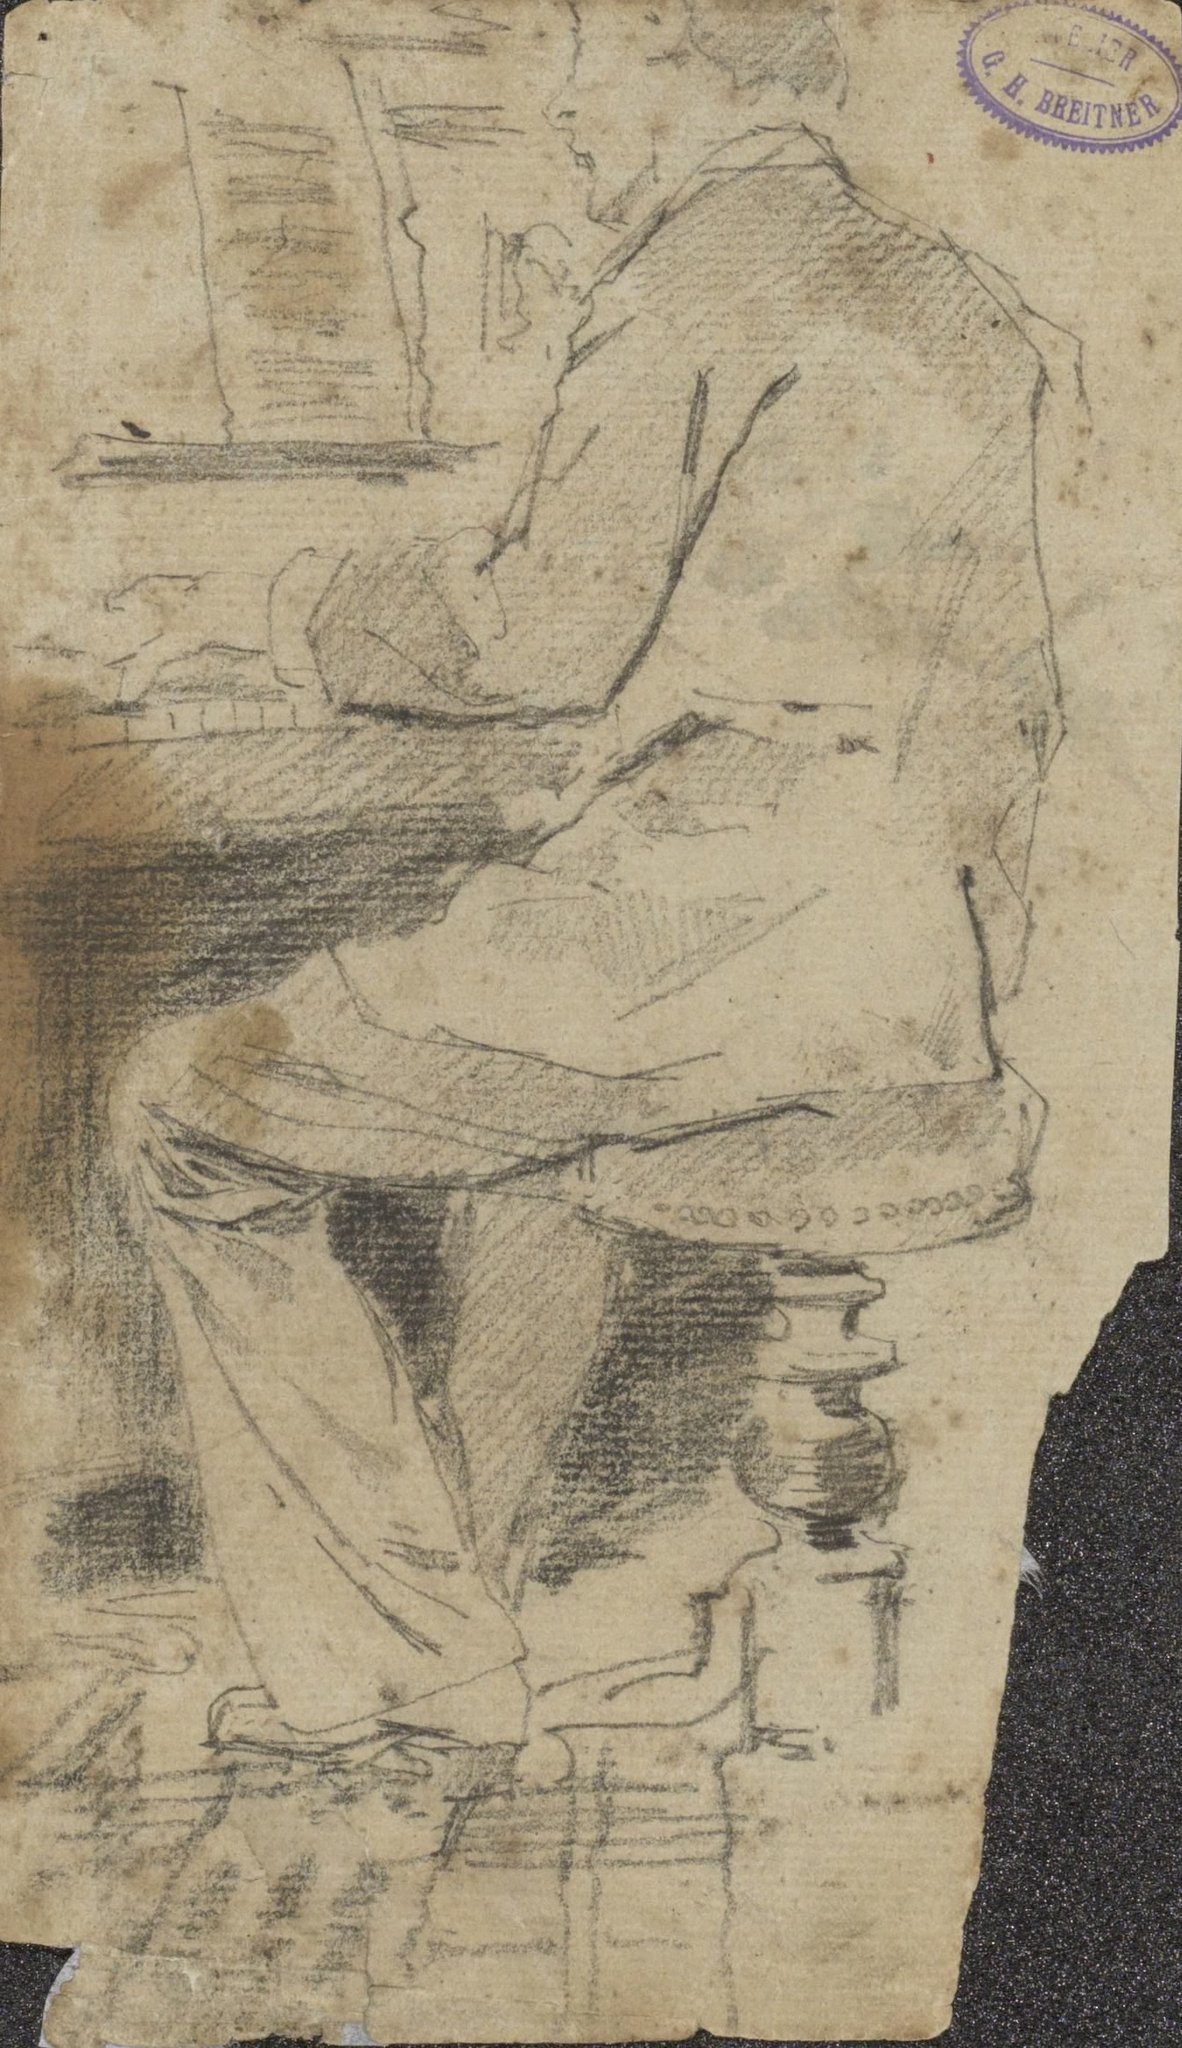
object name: drawing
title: Pianospelende man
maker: george hendrik breitner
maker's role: draughtsman, painter, print maker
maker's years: 1857-1923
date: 1895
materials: chalk, paper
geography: the hague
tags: adult man (+ sitting), one person playing an instrument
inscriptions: workshop stamp: Lugt 291d